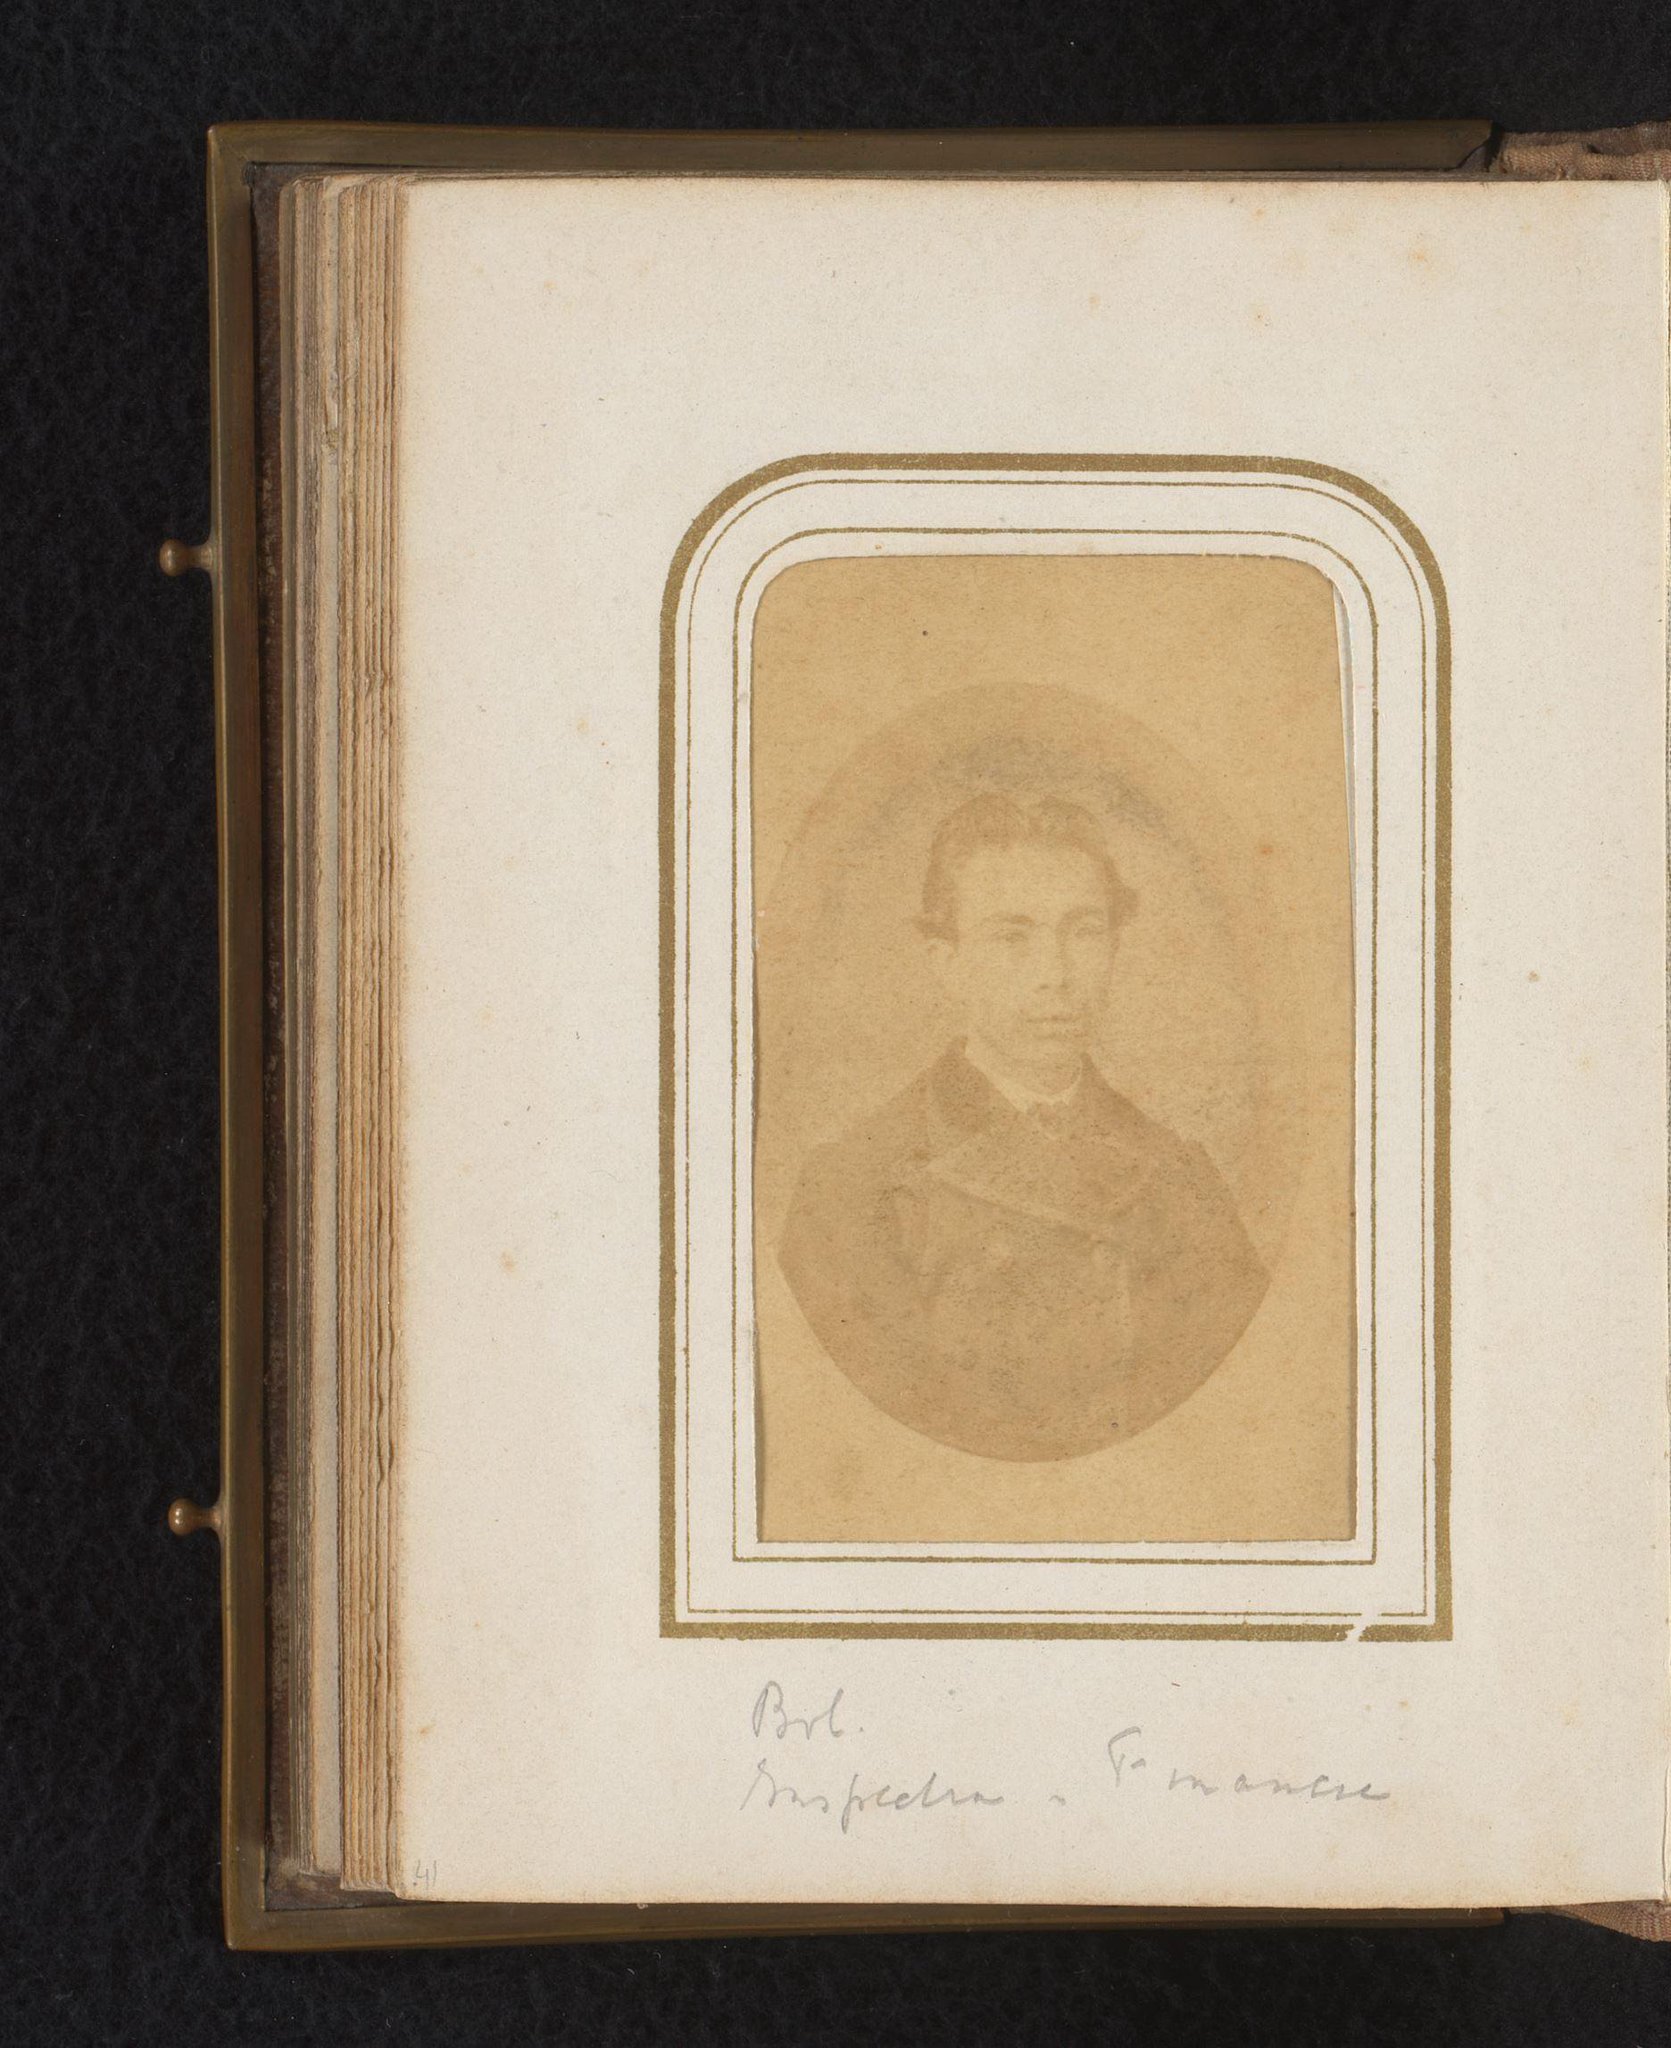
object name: album leaf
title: Portret van een man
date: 1867-1879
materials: cardboard, photographic support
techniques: albumen print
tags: adult man, historical persons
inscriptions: annotation: ‘Bol/ Inspecteur Financiën’, inscription: ‘Kannemans en zoon/ Artiste Photographen/ van/ [...]/ Breda/ Groote Markt/ D.15 [...]’, annotation: ‘Bol/ Insp Financiën’